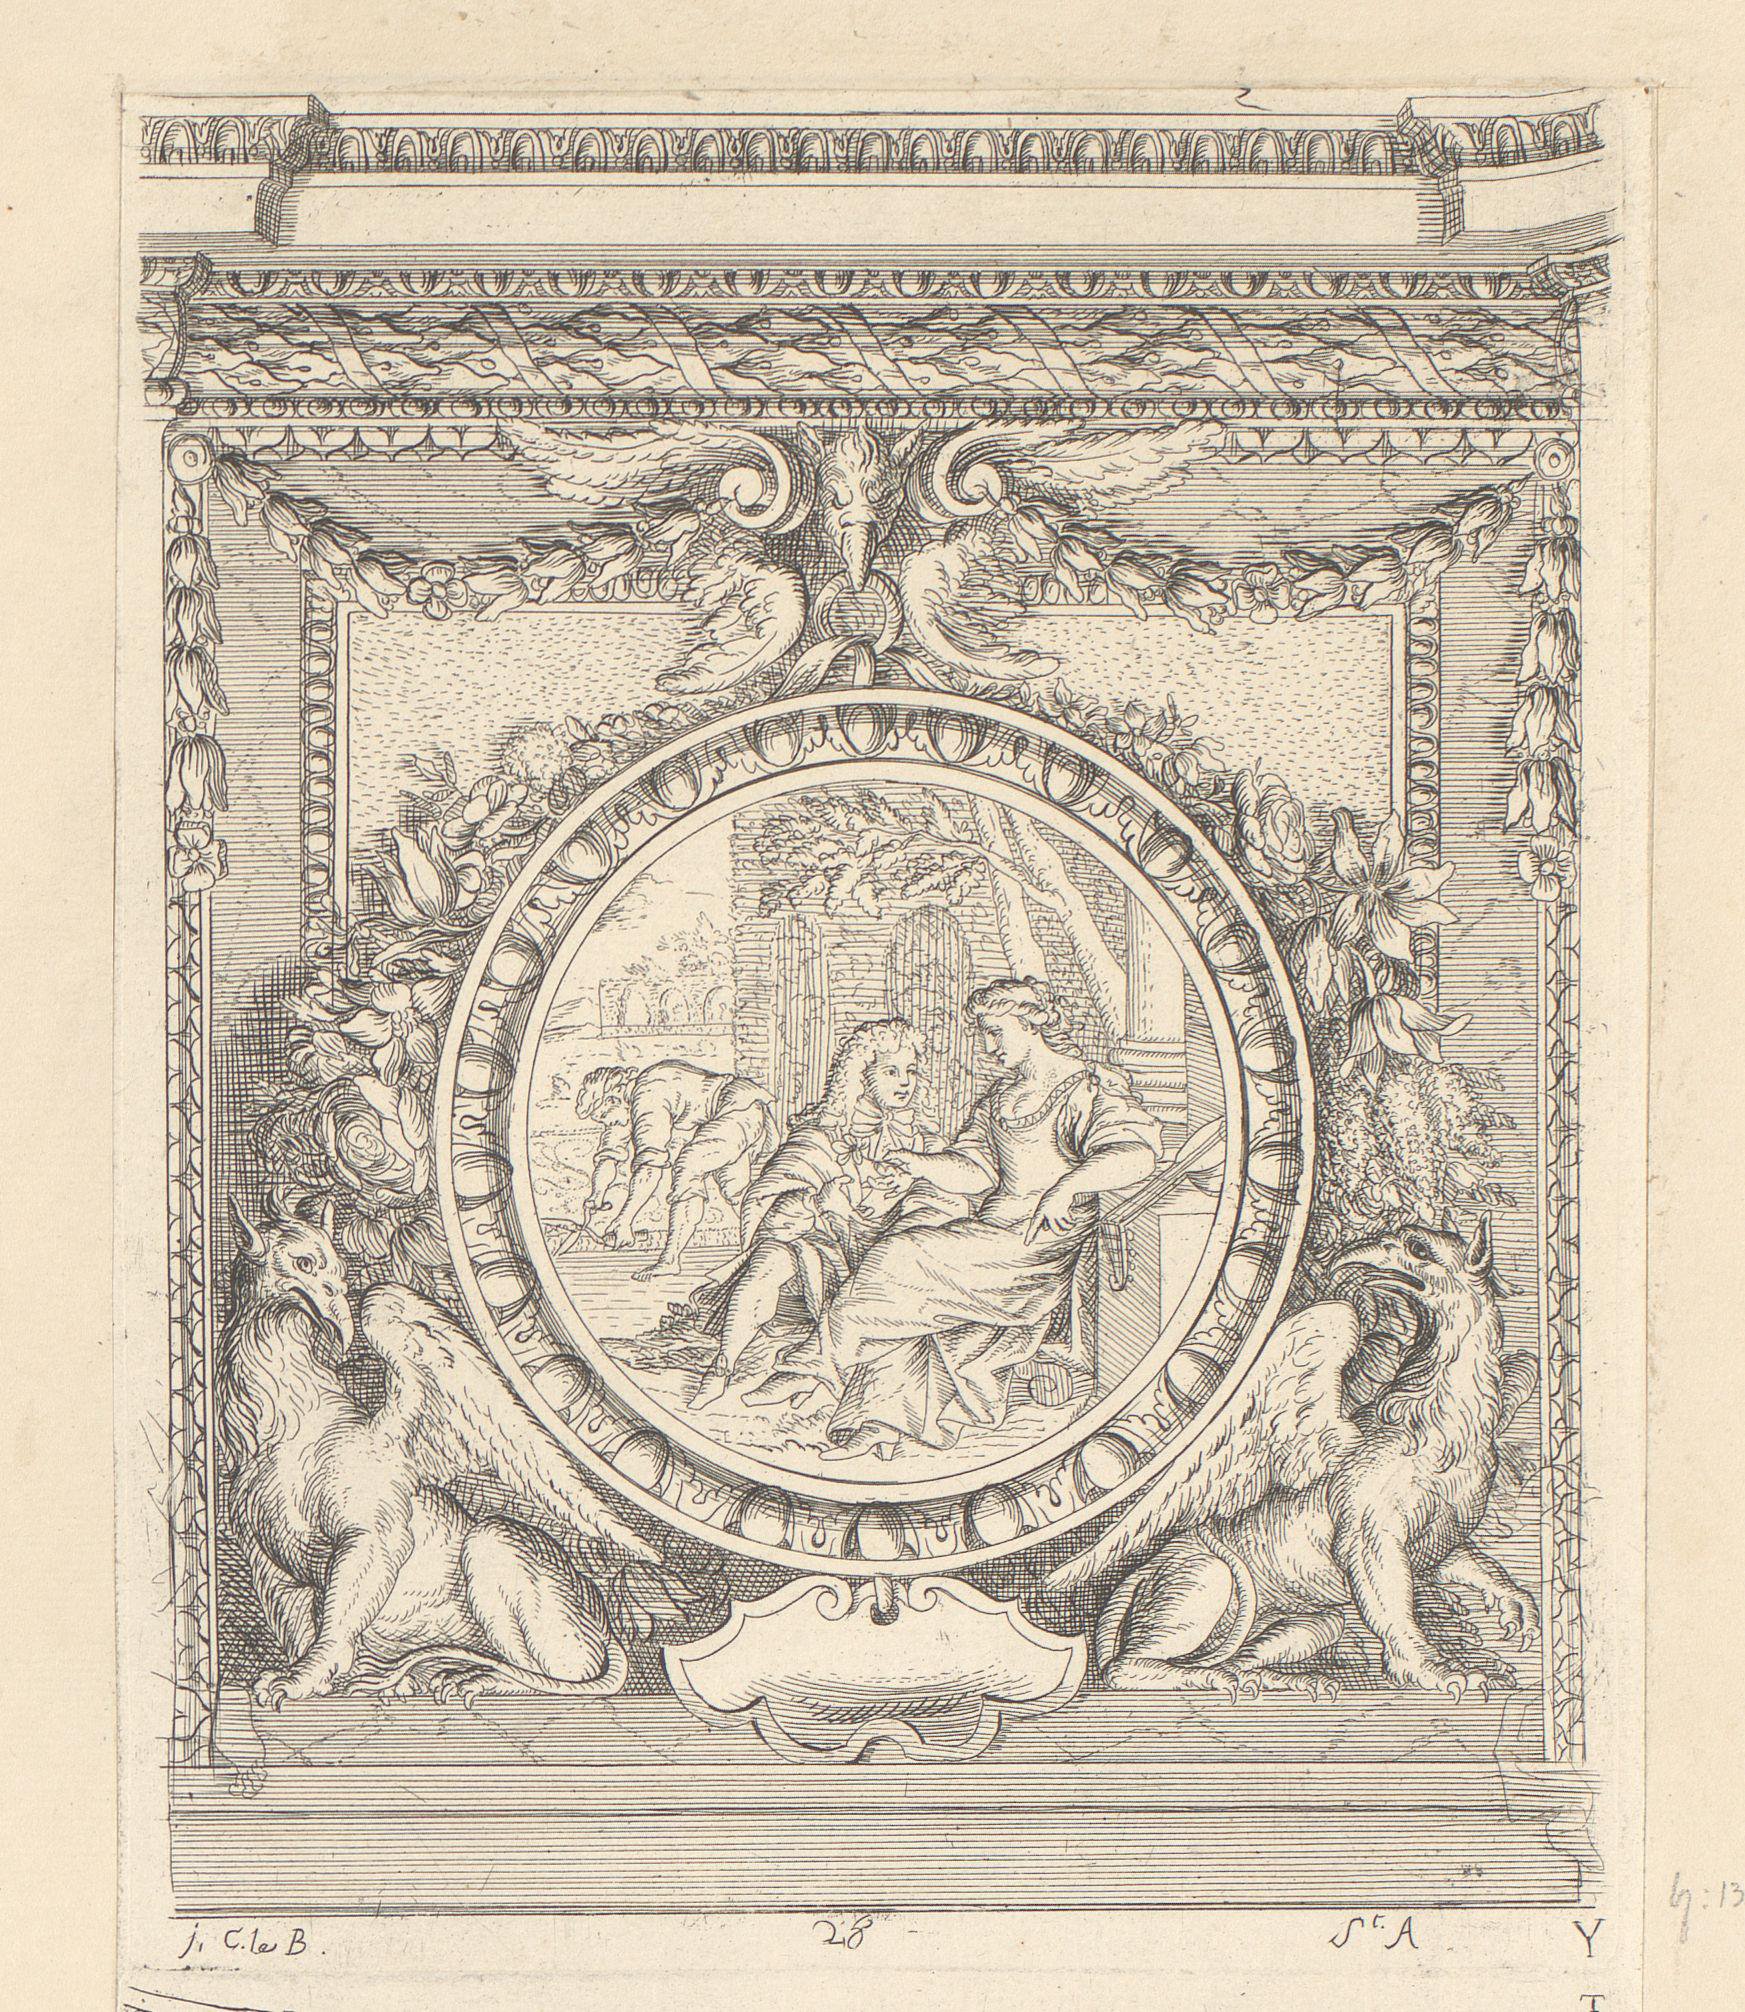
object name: print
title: Werken van Charles le Brun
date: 1695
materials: paper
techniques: etching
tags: griffin (lion/eagle); 'griffo' (ripa), ornaments ~ art, (decorated) ceiling, couple of lovers, paris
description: Een griffioen aan weerszijden van een medaillon met daarop een man die aan de voeten van een vrouw zit. Deze prent maakt deel uit van een album.